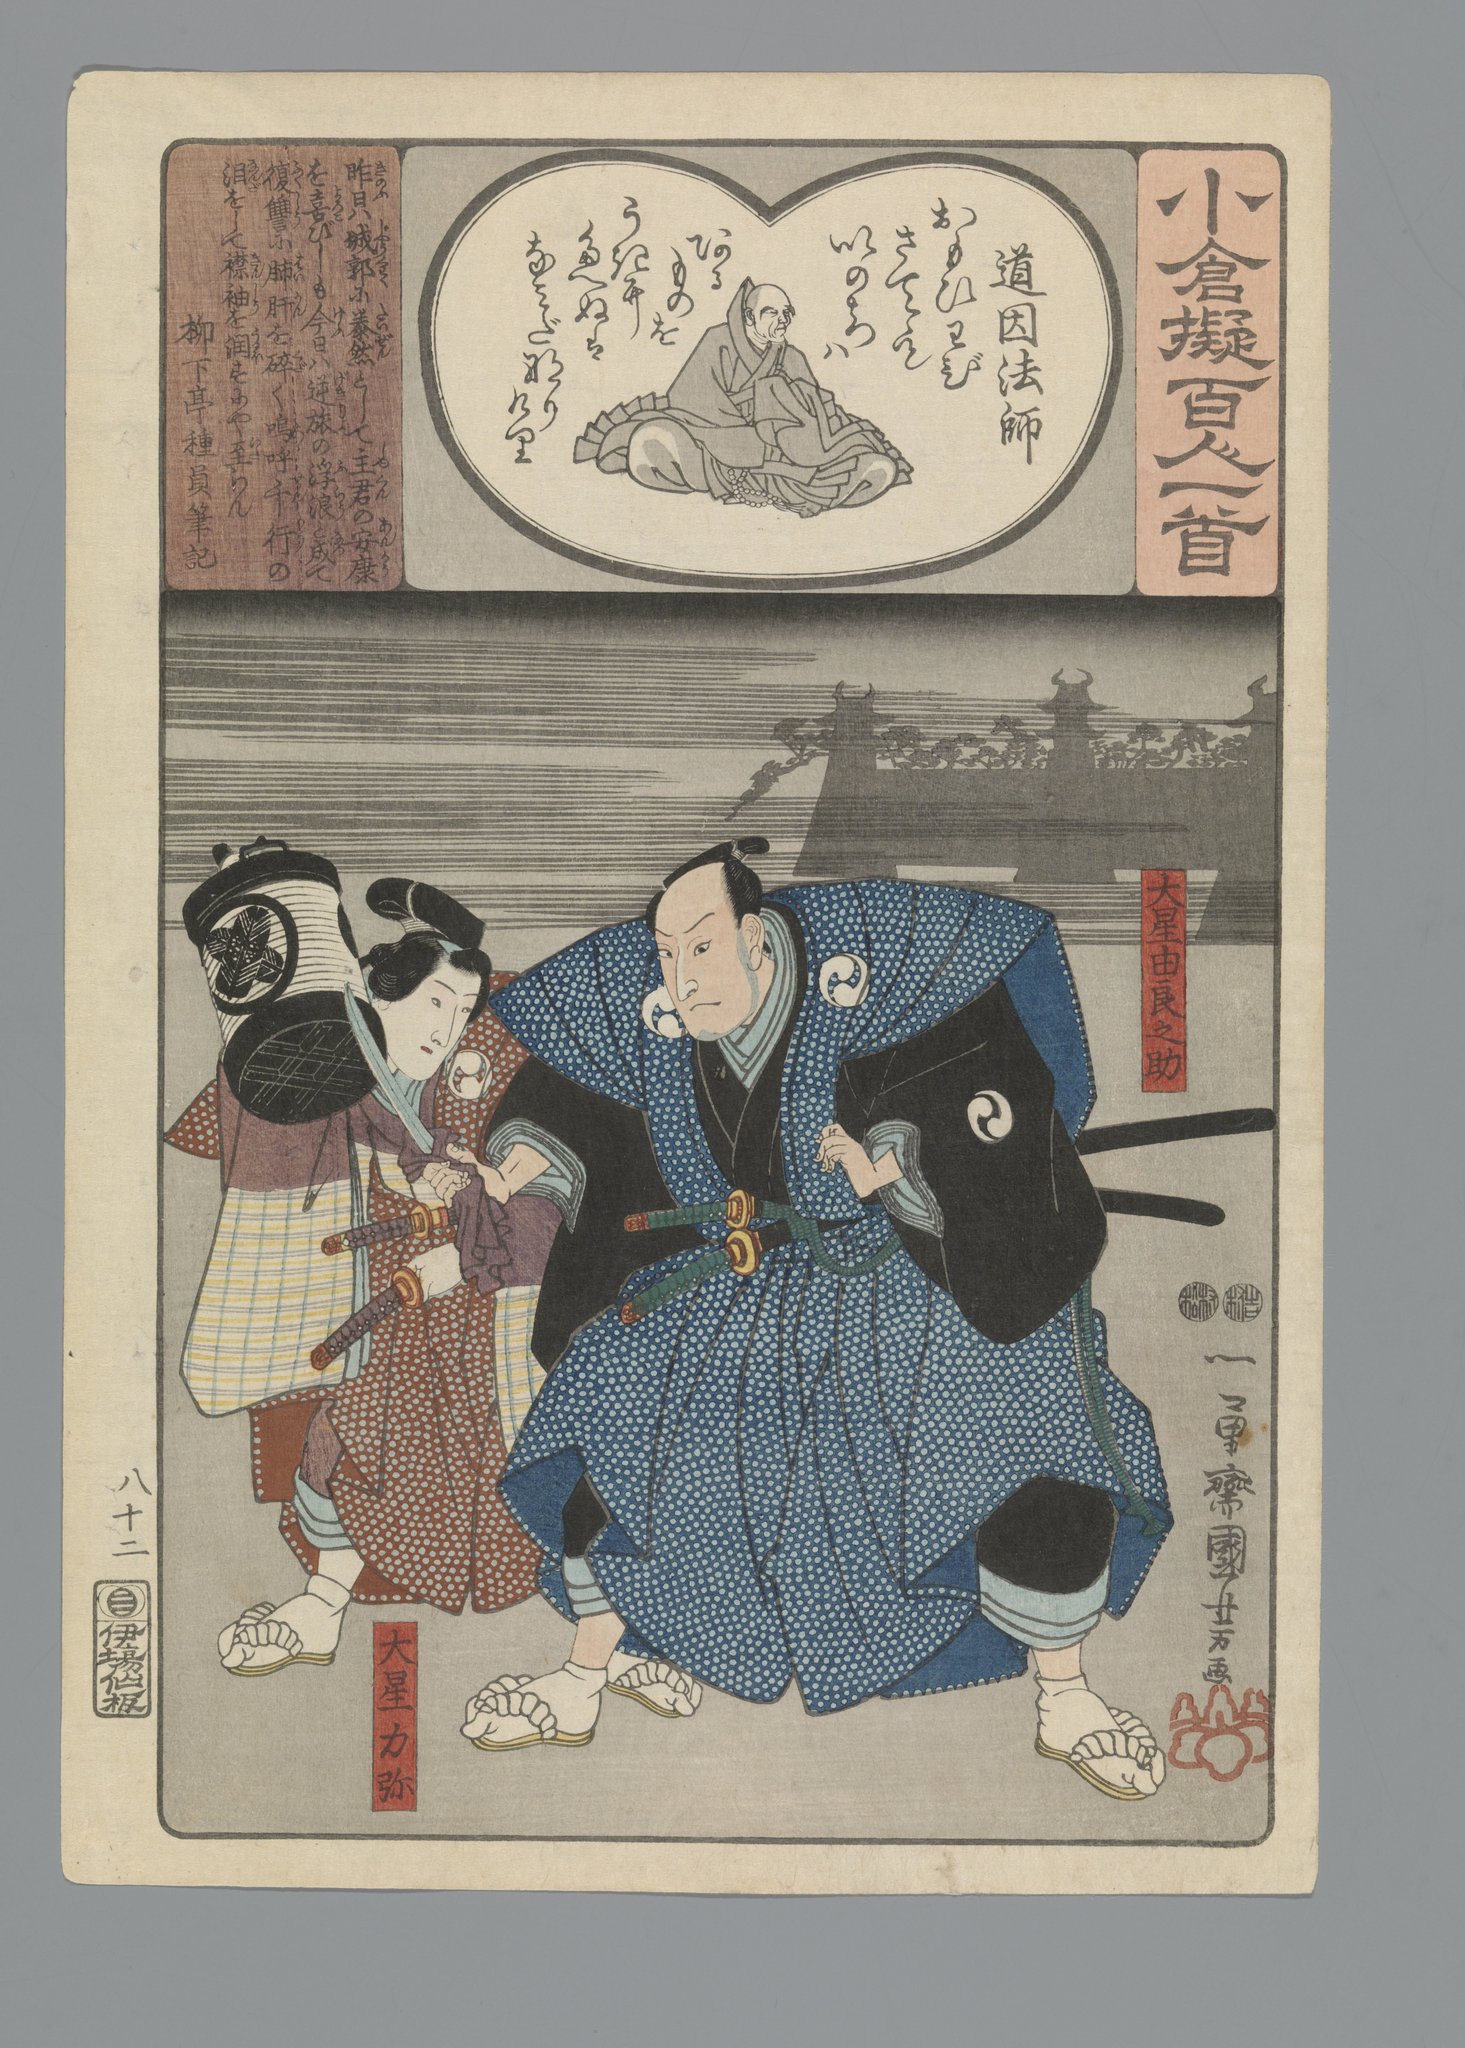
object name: print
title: Ogura Imitation of the One Hundred Poems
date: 1847-1848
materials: paper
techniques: woodcut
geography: japan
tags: hacking and thrusting weapons: dagger, attack ~ siege, lantern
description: Yuranosuke met de dolk waar zijn meester zelfmoord mee pleegde. Zijn zoon Rikiya schijnt hem bij met een lantaarn. Op de achtergrond bestormen 47 samoerai in opdracht van Yuranosuke het kasteel van zijn vijand. Scene uit een kabukitoneelstuk. Gedicht door Dainagon Kintô.